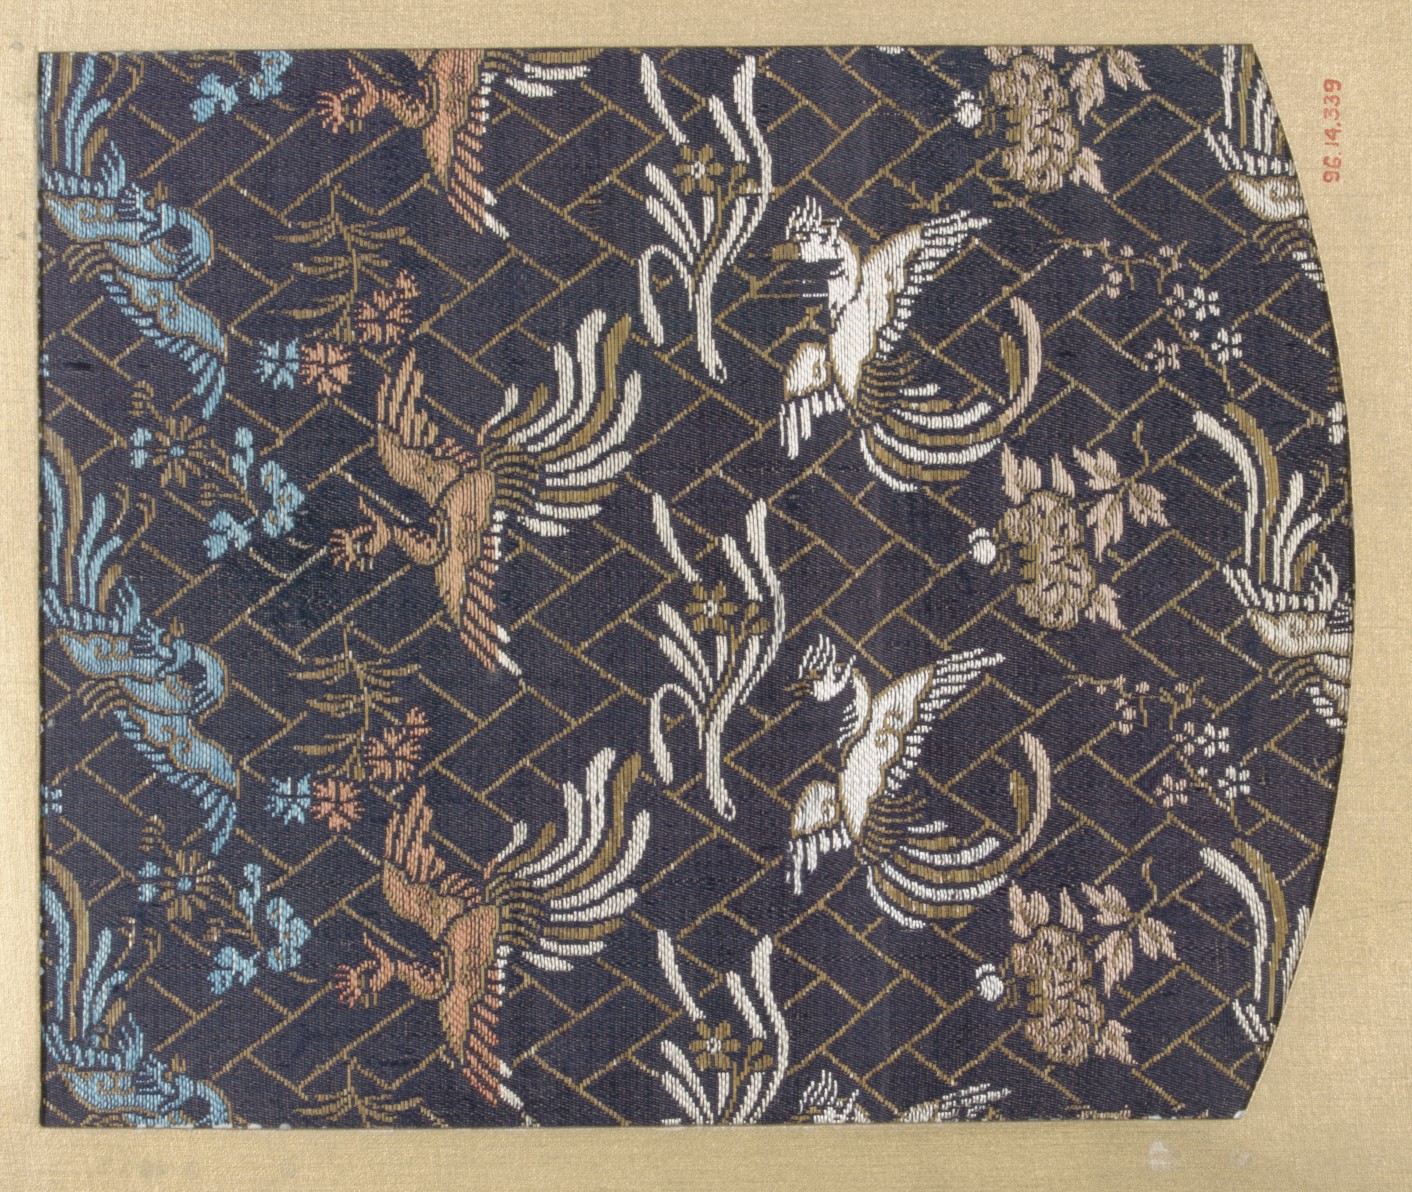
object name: piece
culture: japanese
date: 1701-1900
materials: silk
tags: flowers,leaves